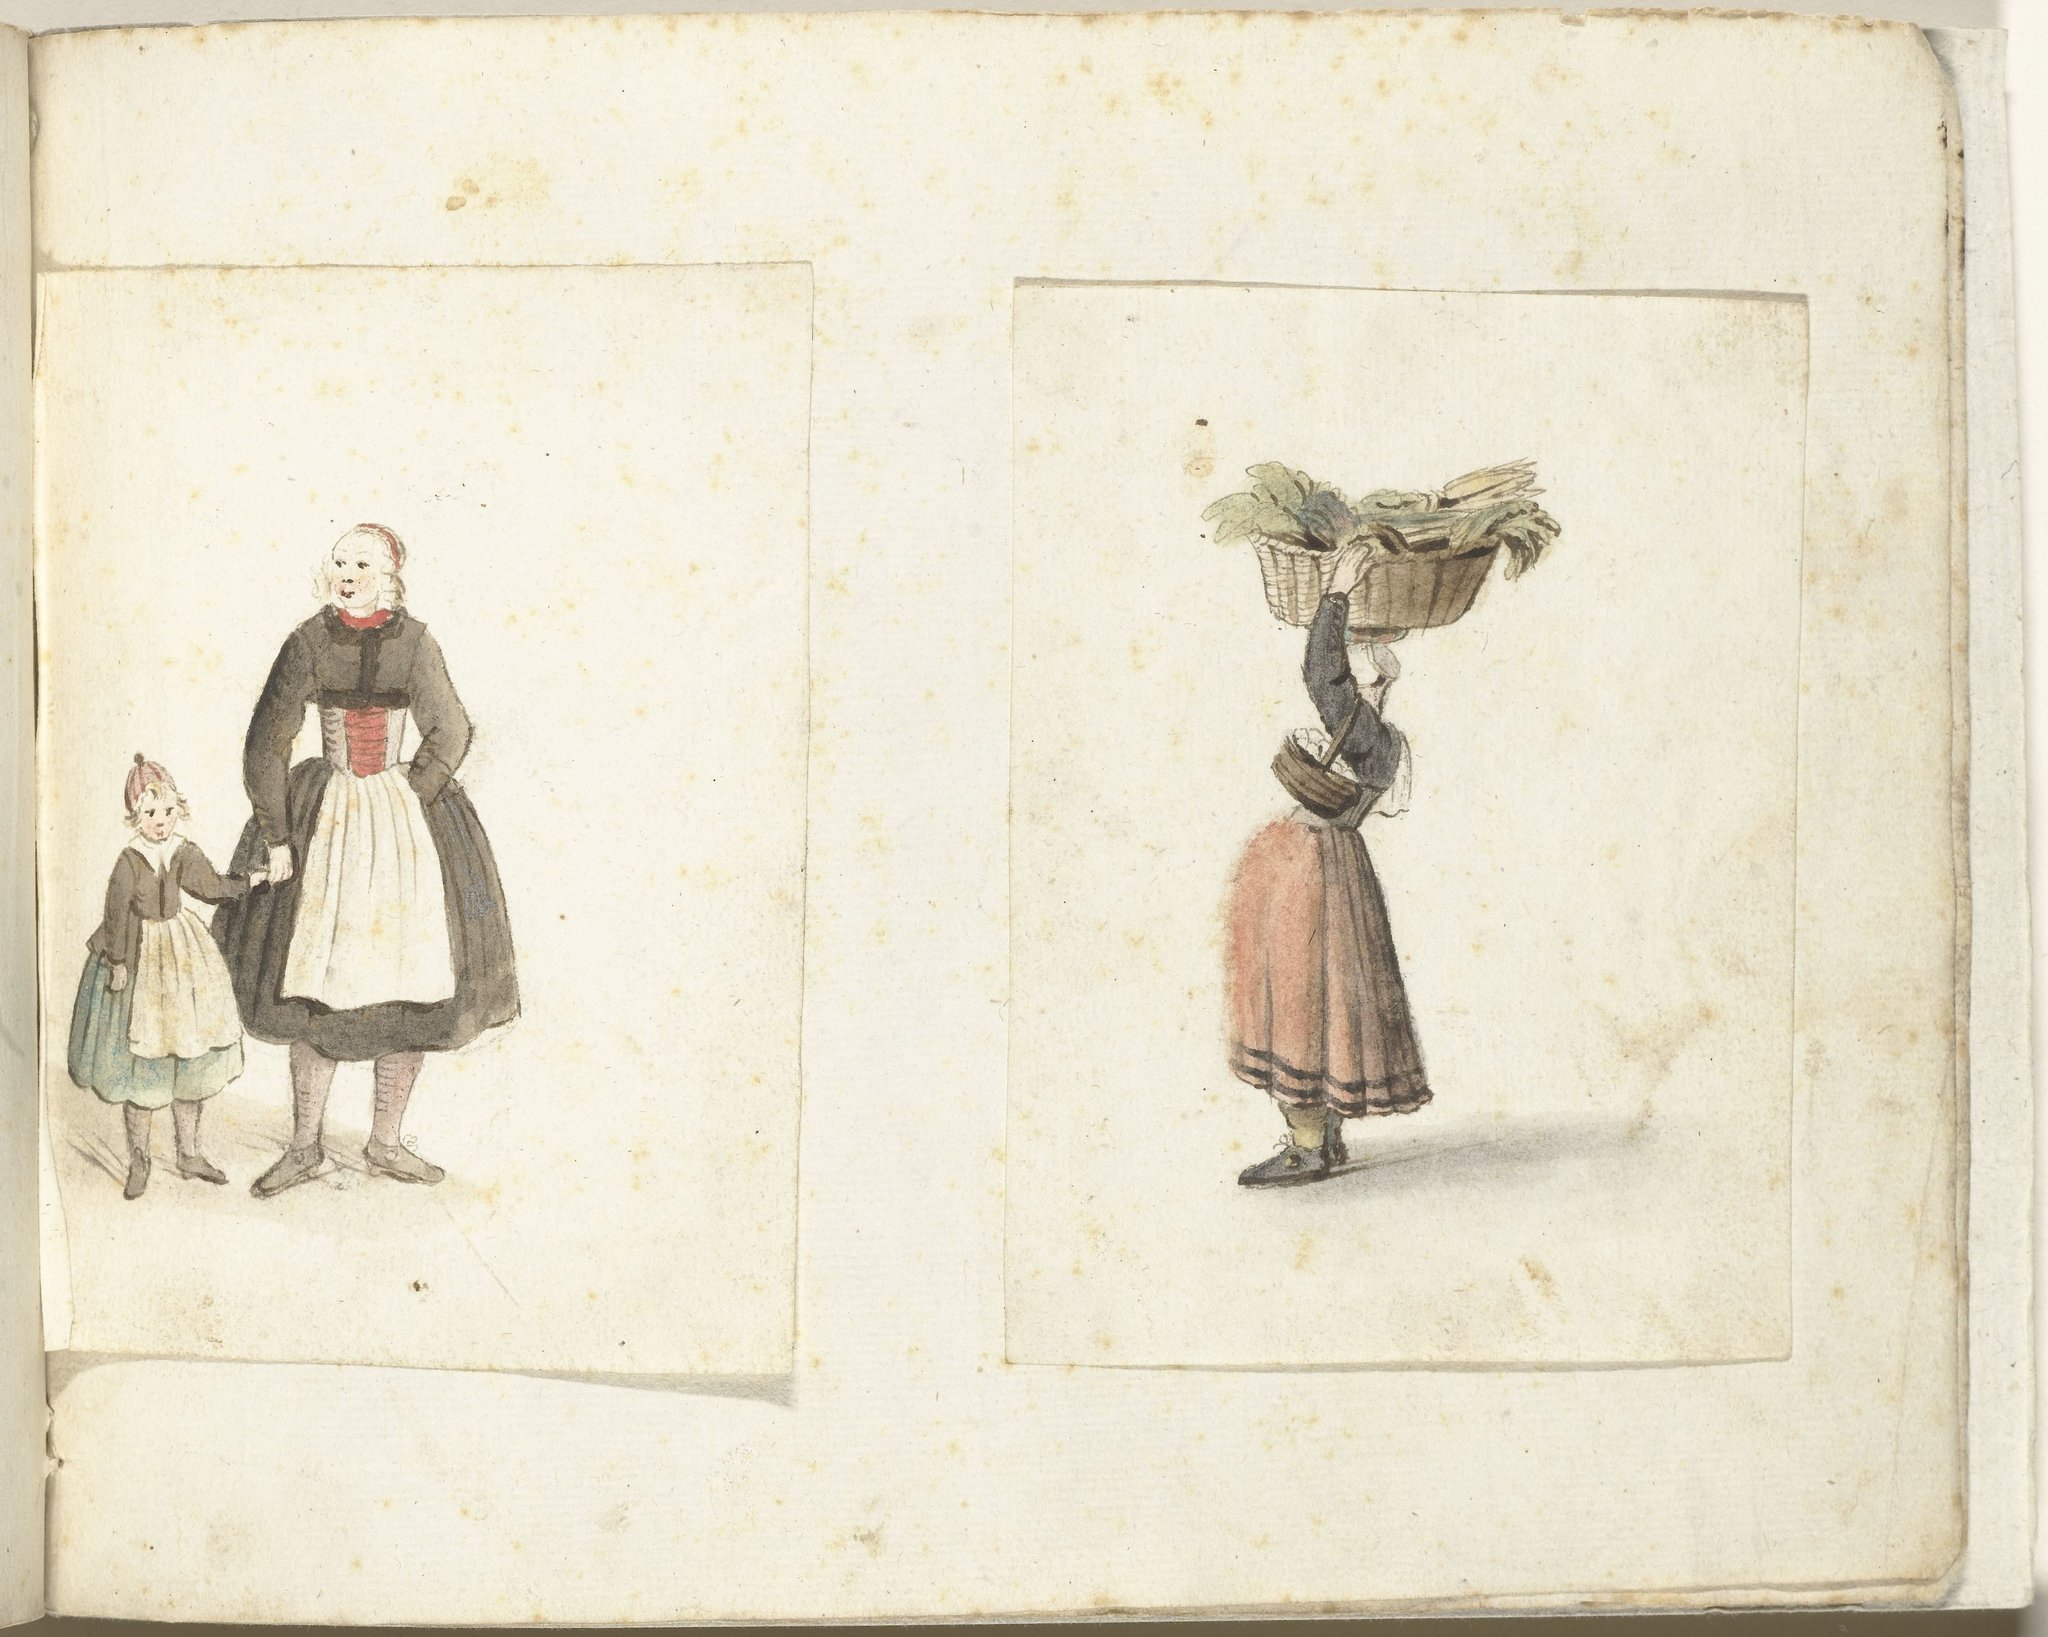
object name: watercolor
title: Noord-Hollandse vrouw met kind en vrouw met manden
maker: gesina ter borch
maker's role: draughtsman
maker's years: 1633-1690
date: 1648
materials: ink, paper, watercolor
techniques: brush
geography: zwolle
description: Twee tekeningen naast elkaar op een blad geplakt. Links een Noord-Hollandse vrouw met een kind, rechts een vrouw met een grote mand op haar hoofd en een kleine aan haar arm.